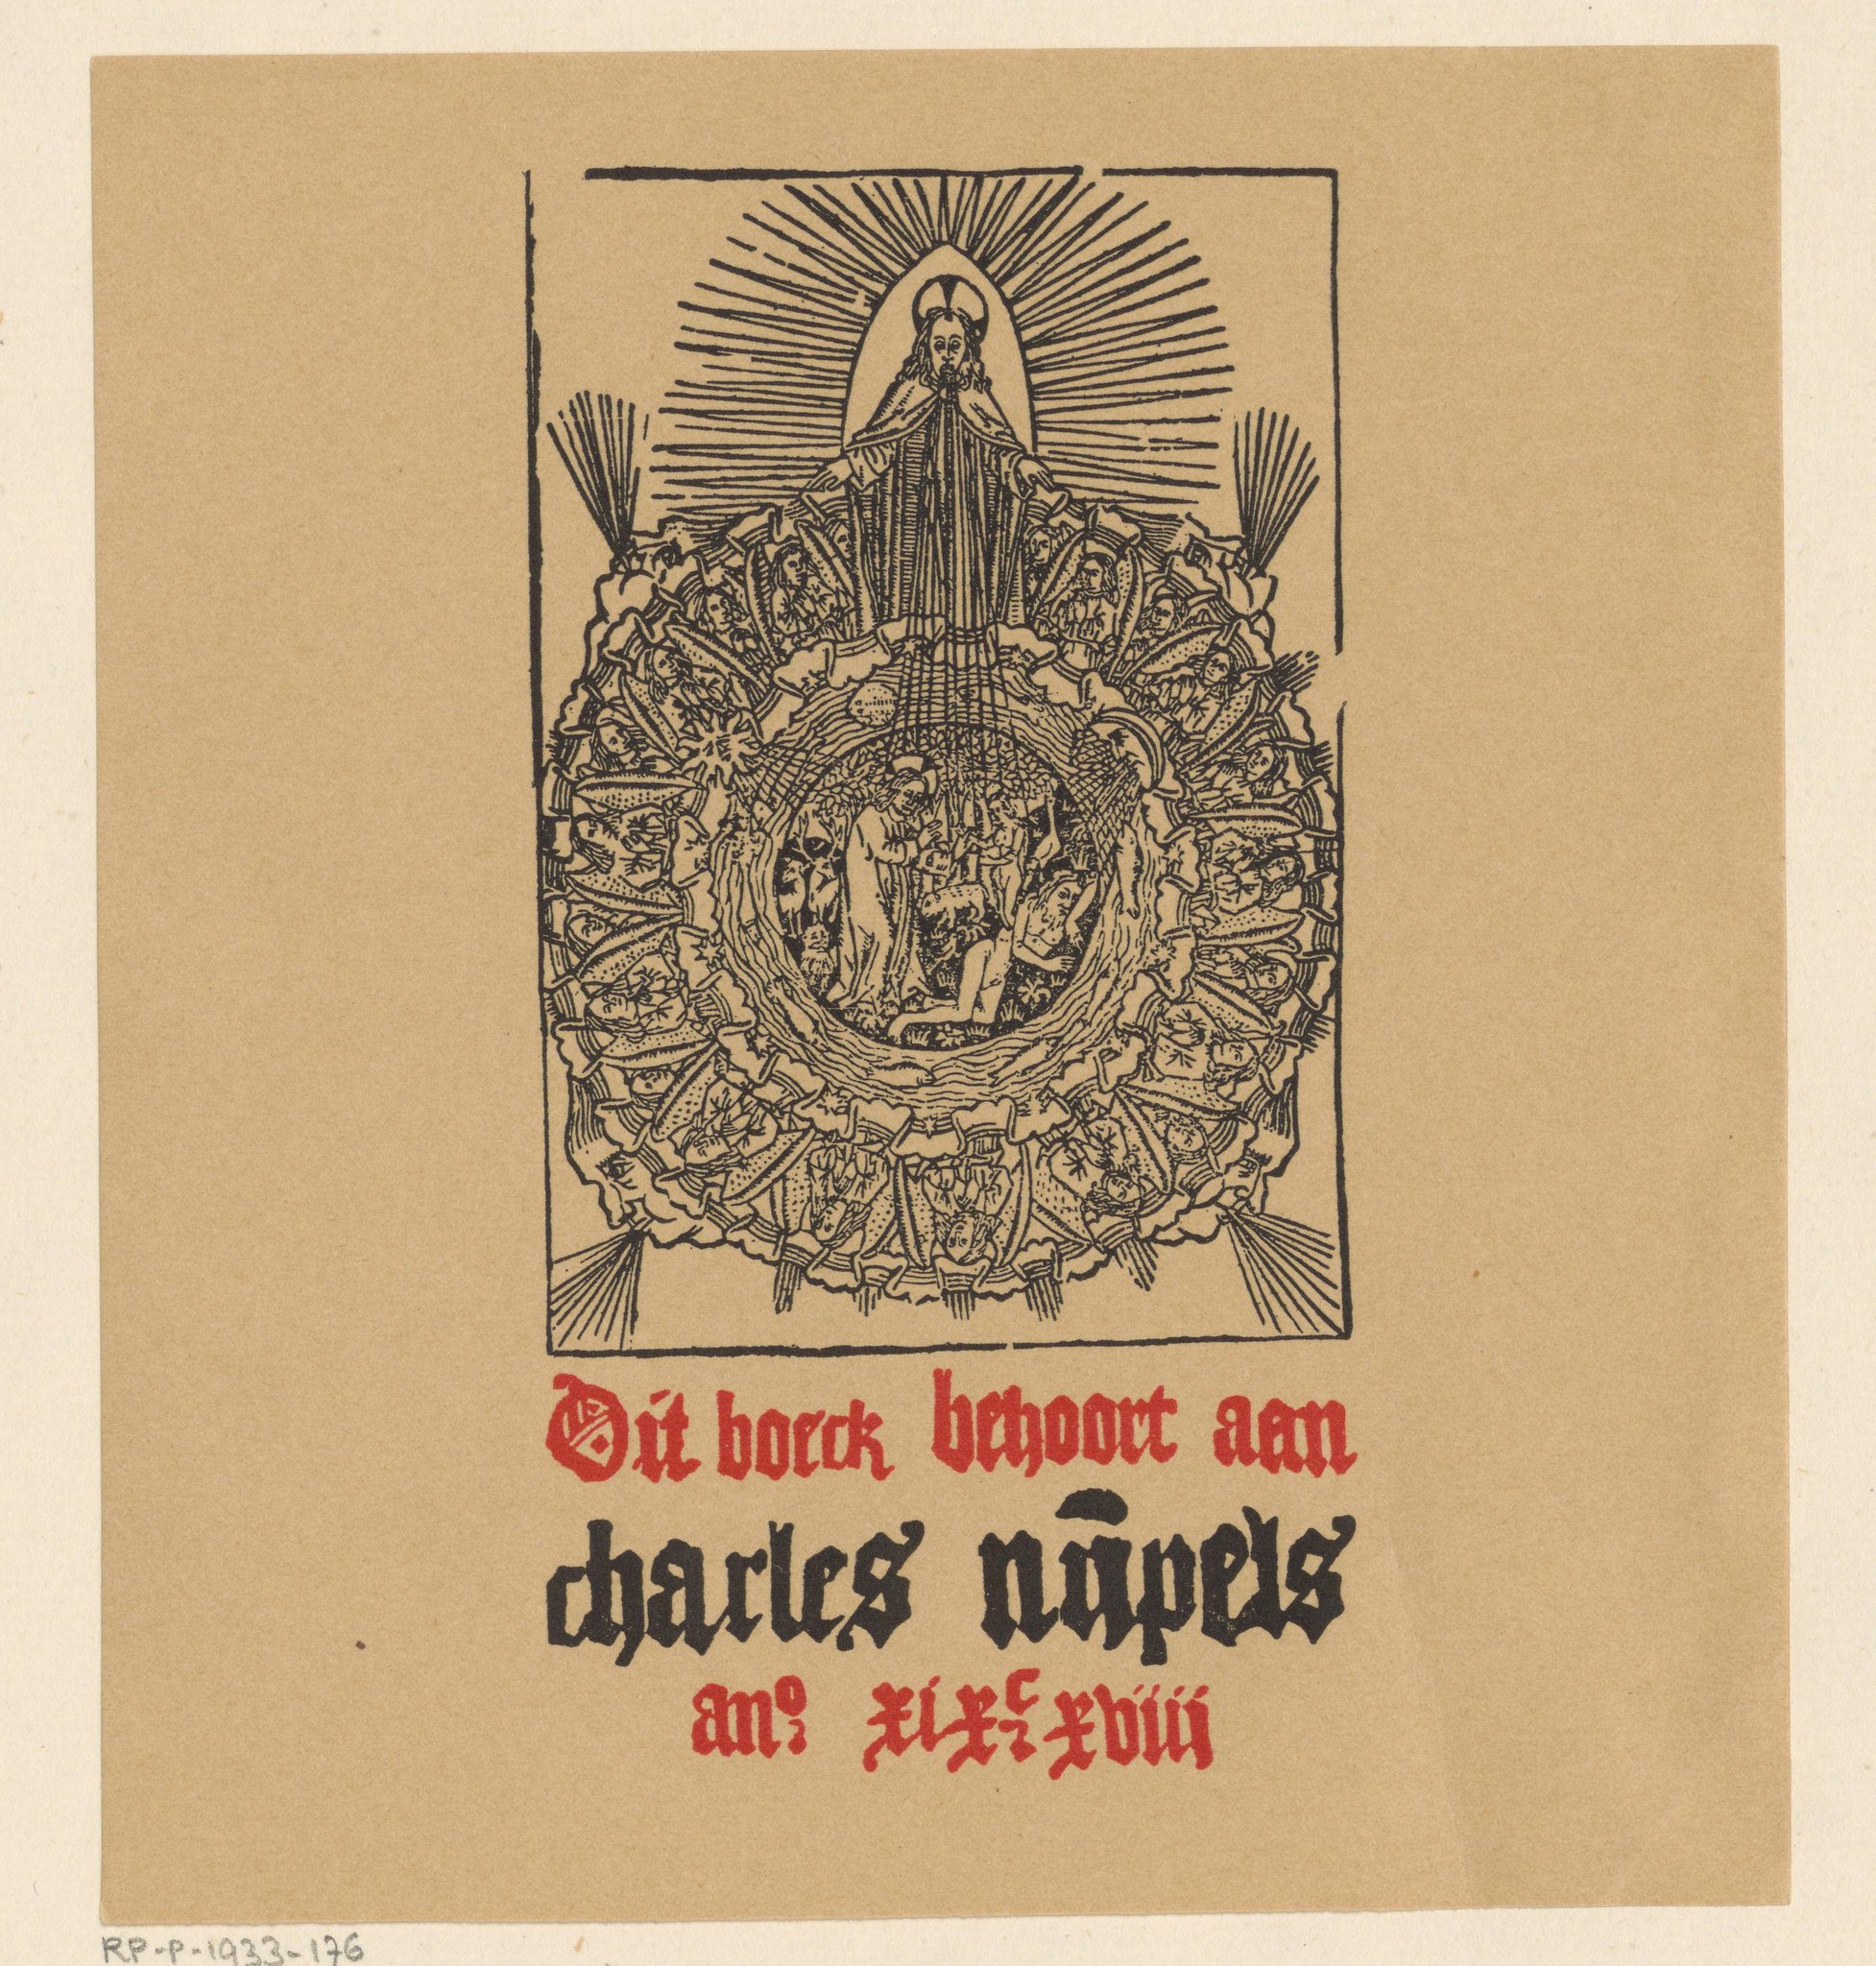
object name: bookplate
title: Ex libris van Charles Nijpels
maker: charles nijpels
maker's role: print maker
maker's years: 1895-1952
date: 1918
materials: paper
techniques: printing block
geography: netherlands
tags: maastricht, print maker, charles nijpels, god the father, winds, creation of eve, angels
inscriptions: collector's mark: Lugt 2760